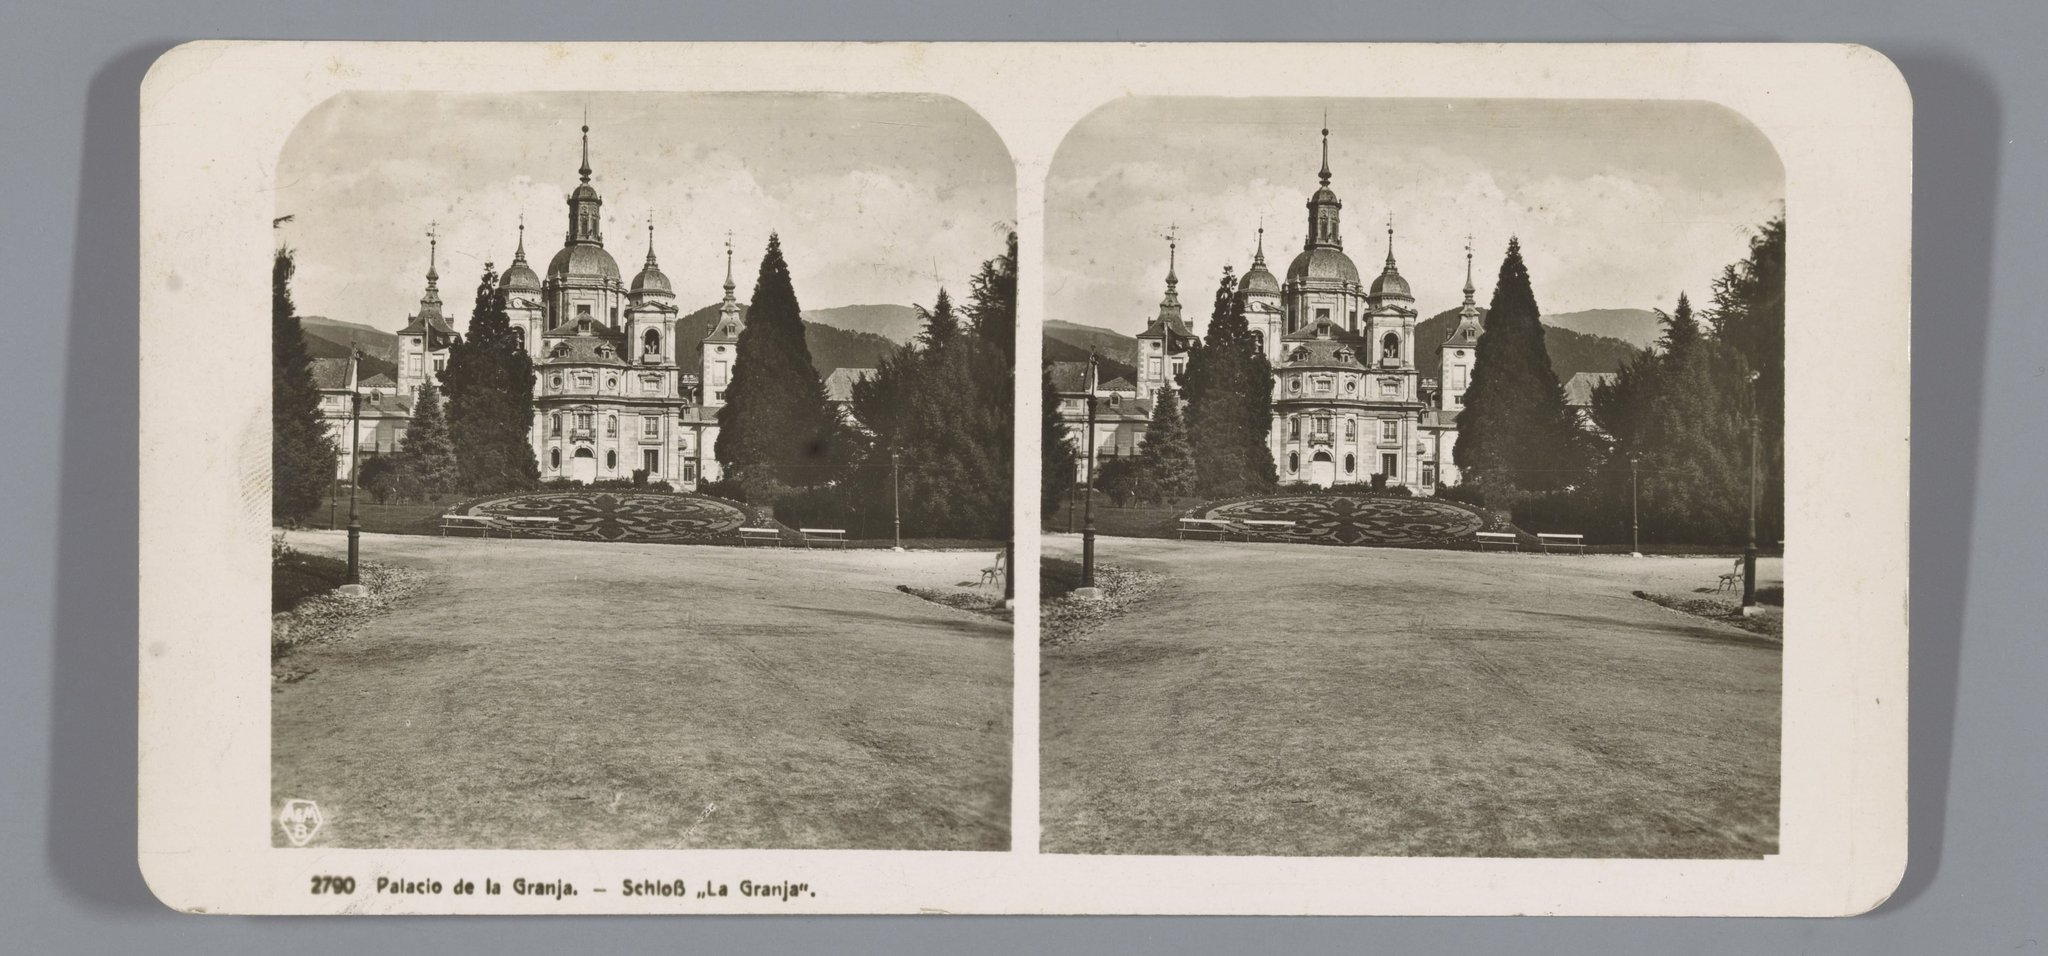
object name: stereograph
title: Gezicht op het Koninklijk Paleis van La Granja de San Ildefonso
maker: Anonymous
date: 1900-1940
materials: cardboard, photographic support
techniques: gelatin silver print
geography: san ildefonso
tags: palace, façade (of house or building)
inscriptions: inscription, number: ‘2790’